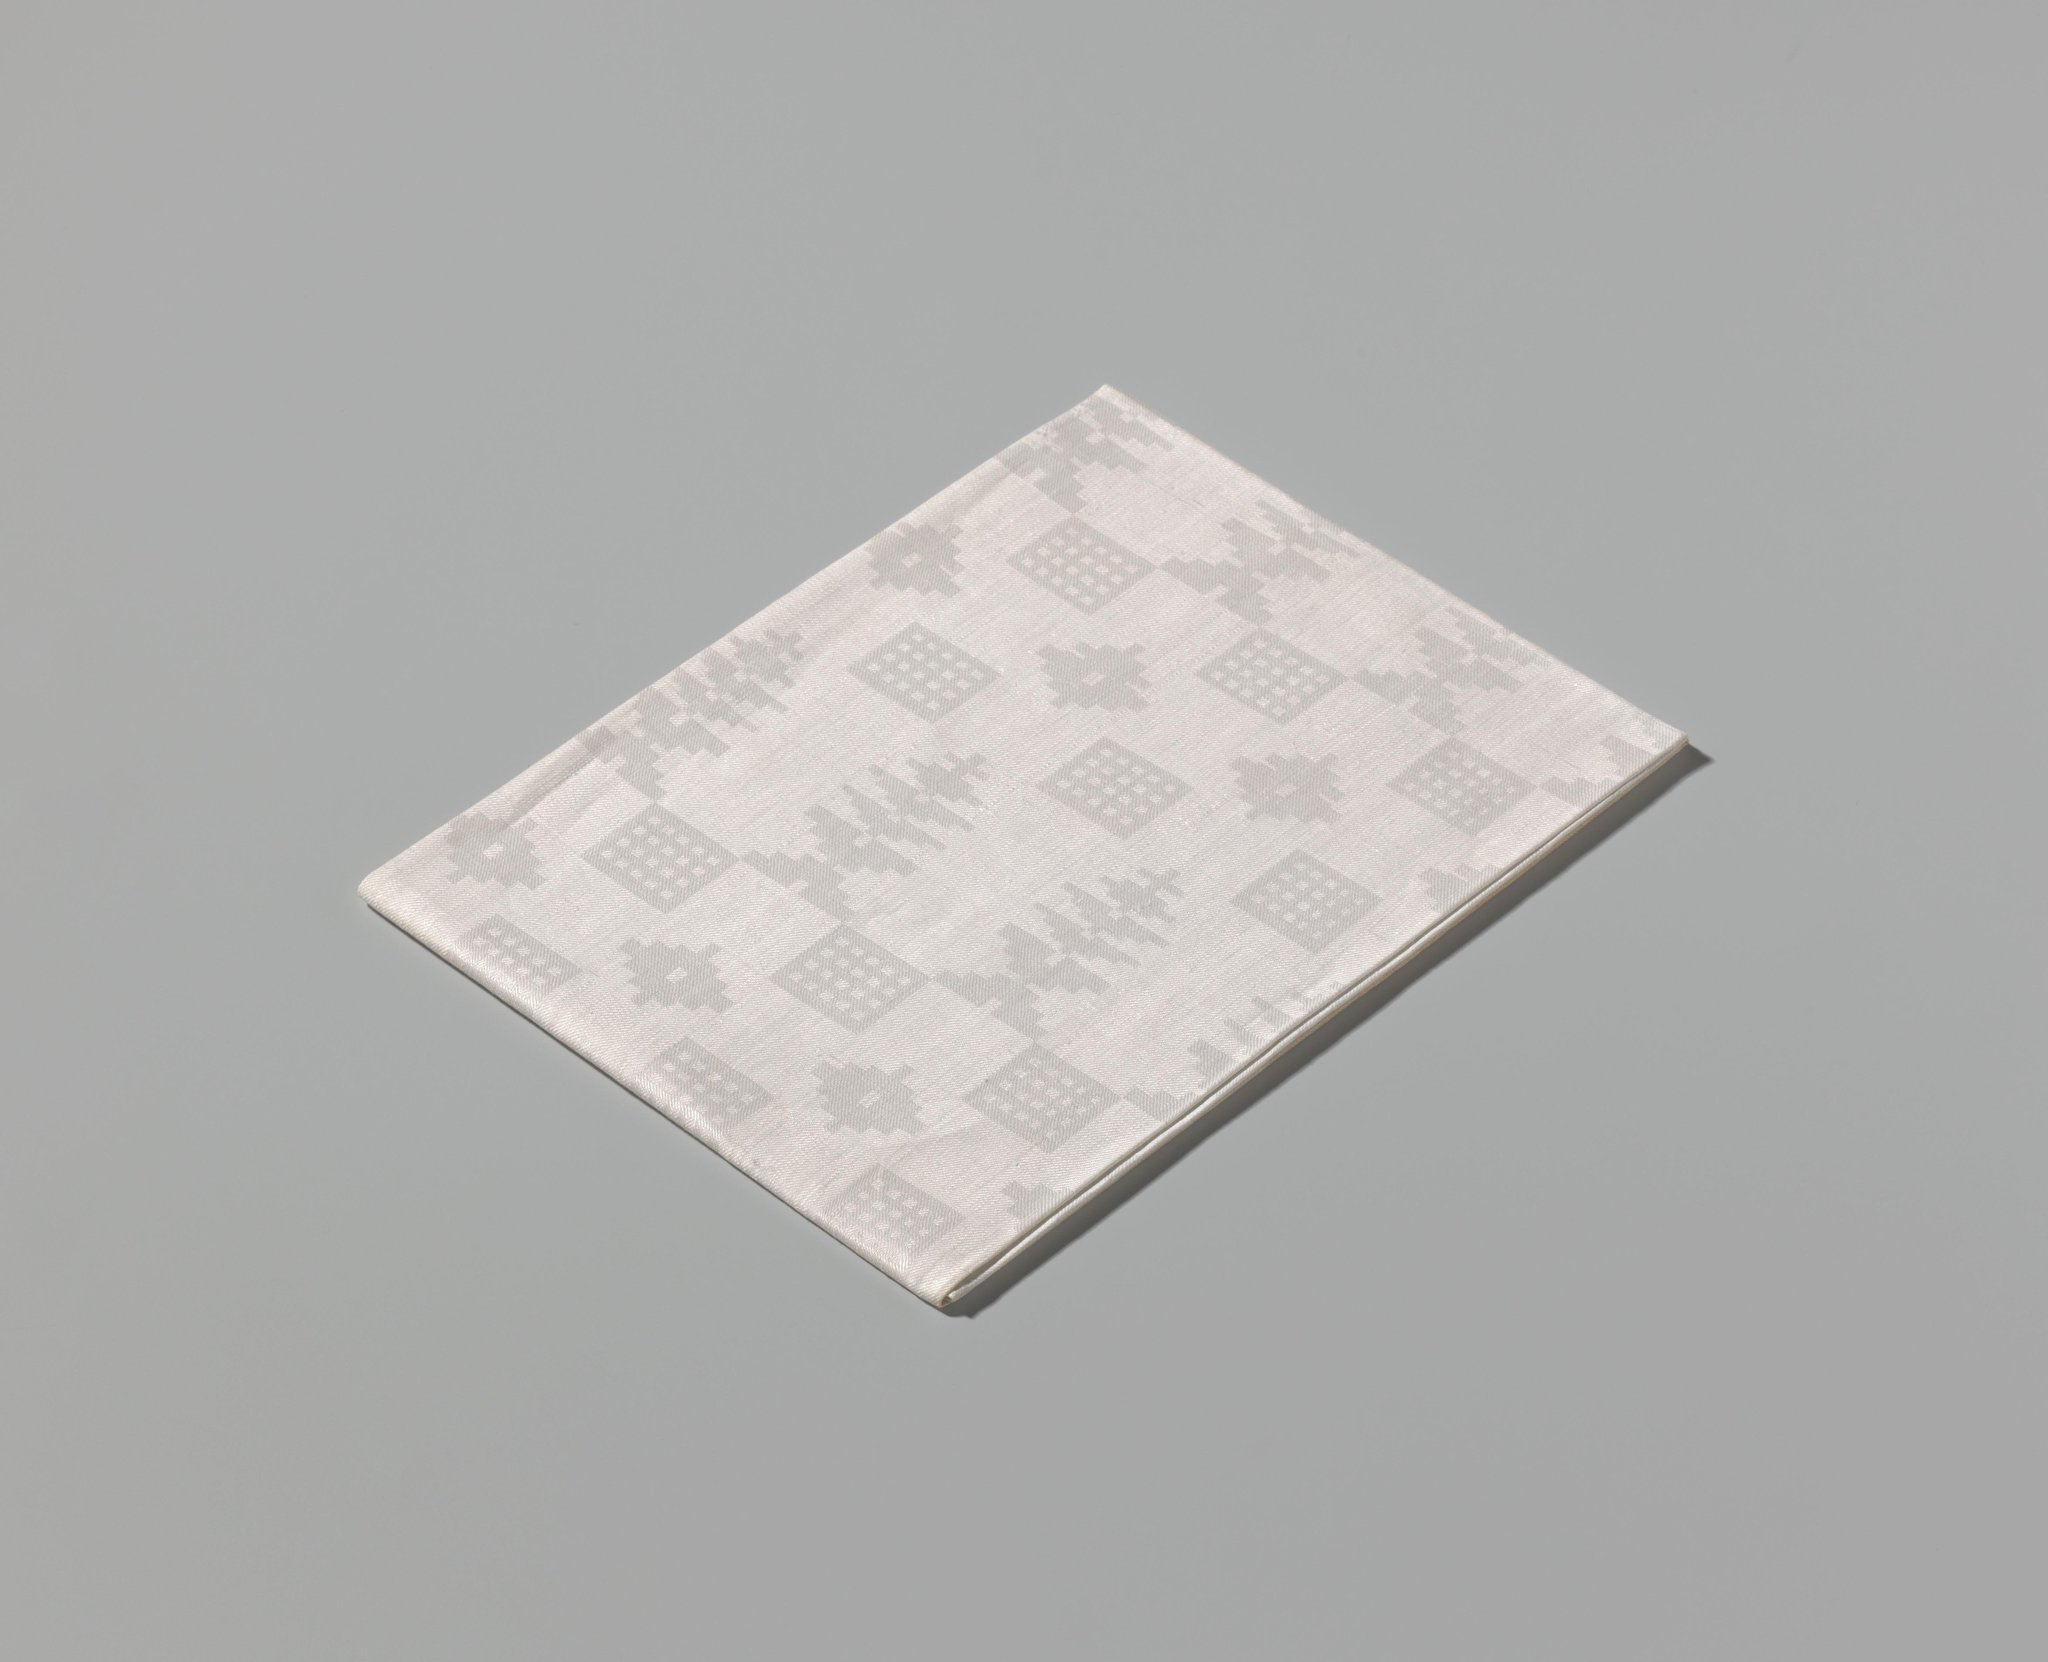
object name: napkin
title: Servet van linnen met pellenpatroon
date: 1730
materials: linen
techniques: twill, peeled fabric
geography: northern netherlands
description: wit linnen servet met pellen patroon, merk kroon WG 42 en 1730